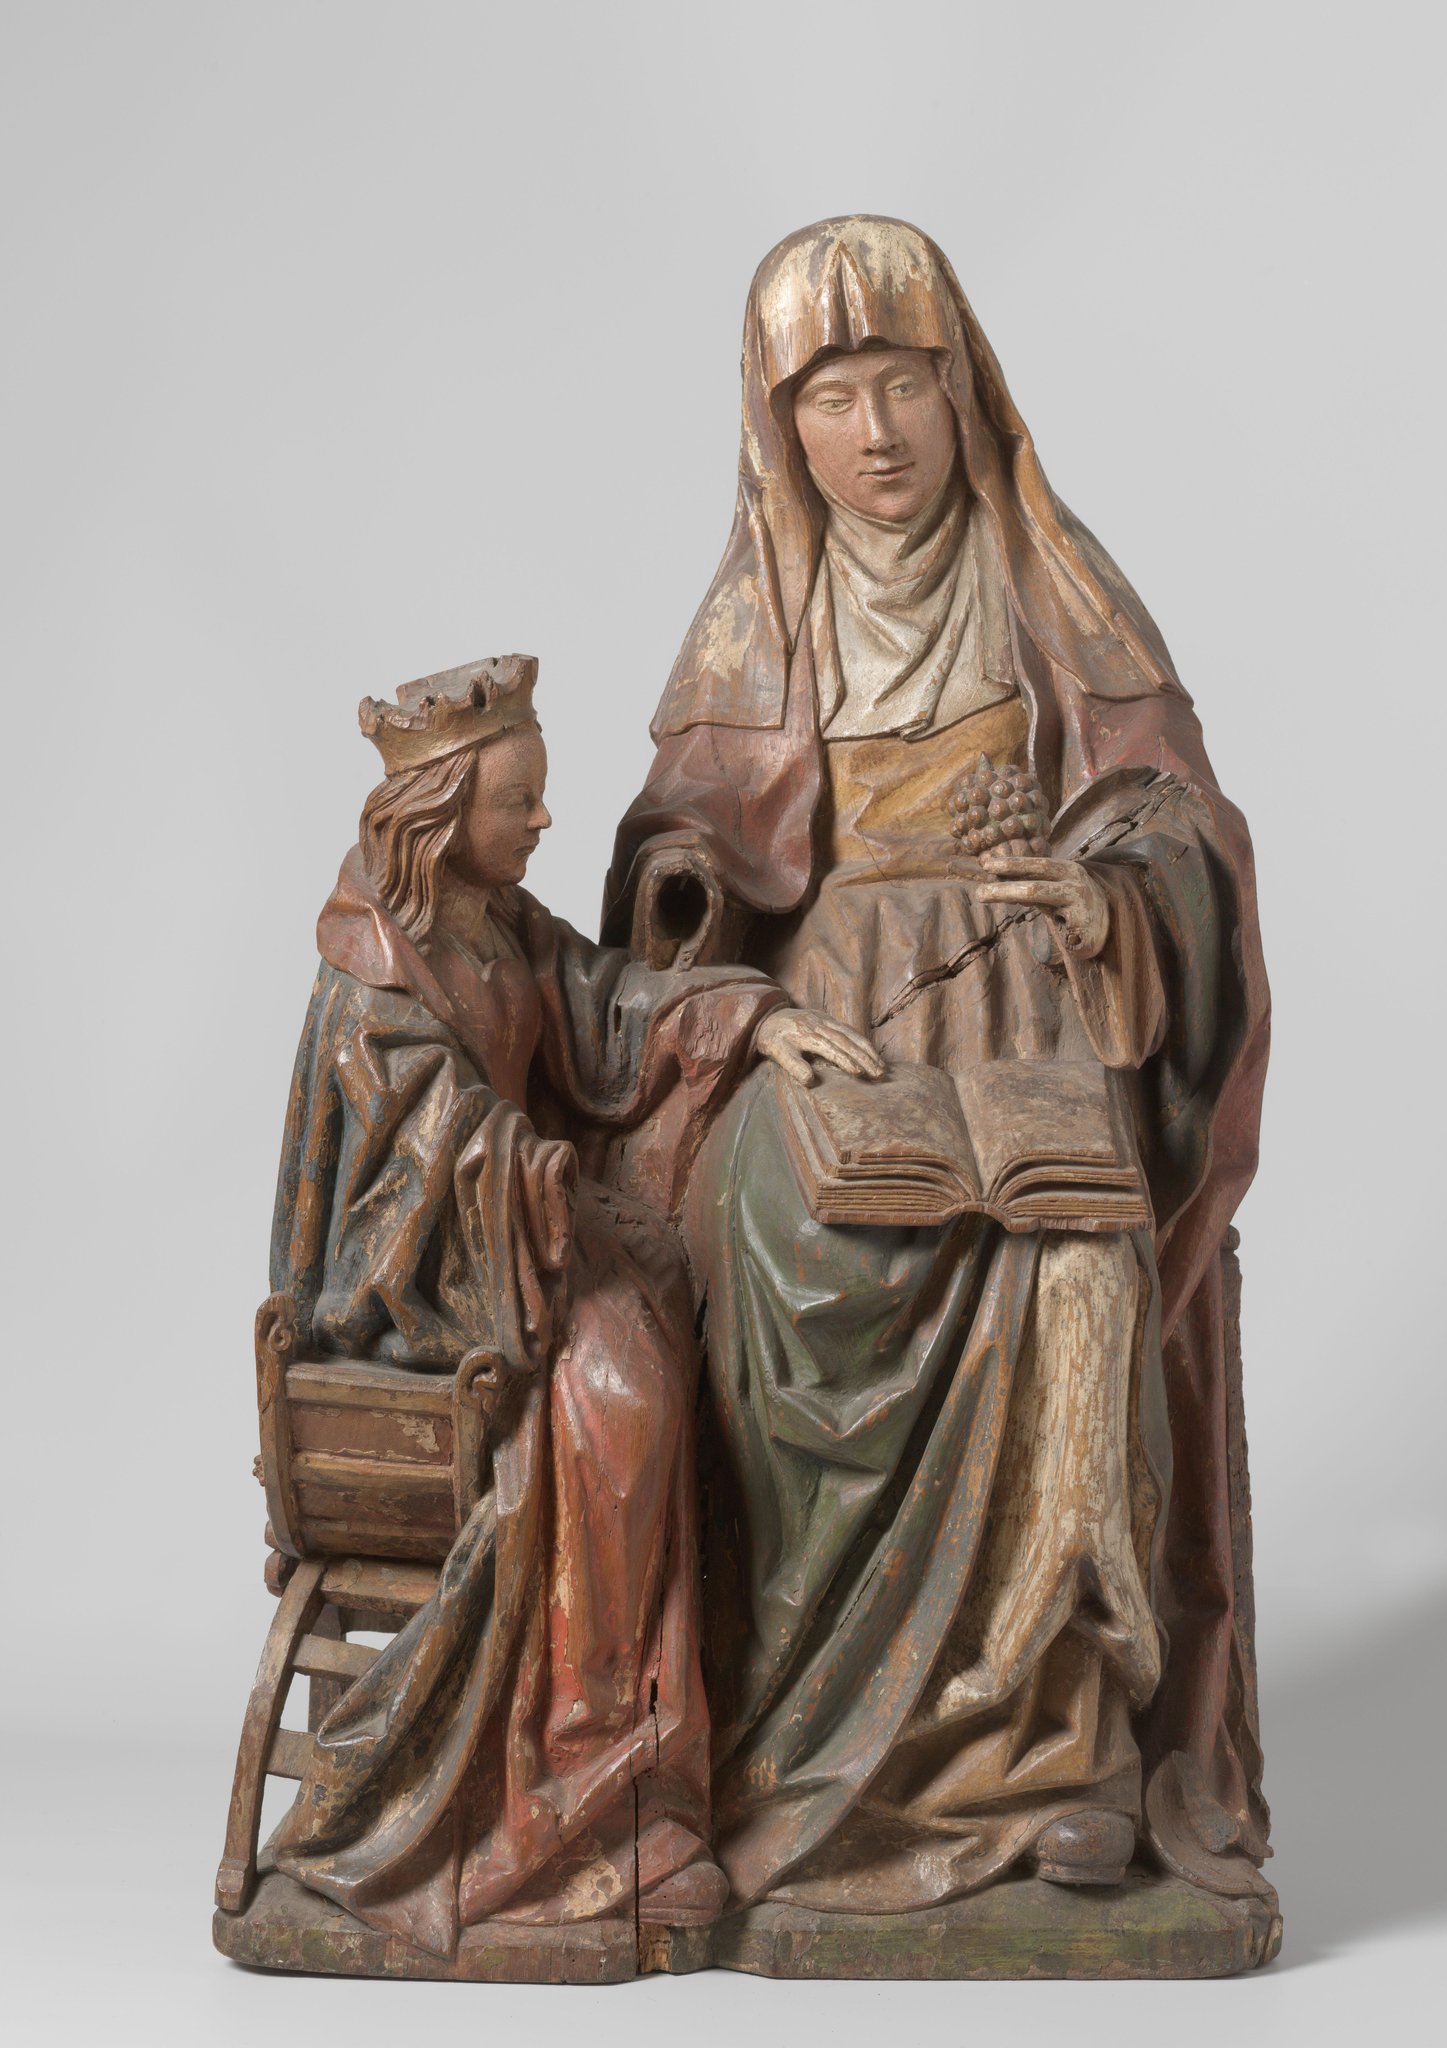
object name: sculpture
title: The Virgin and Child with St Anne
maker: Anonymous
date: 1500-1525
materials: wood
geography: meuse area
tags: 'anna selbdritt', i.e. anna, mary and christ-child close together